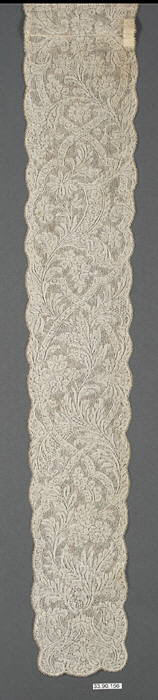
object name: lappet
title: Lappets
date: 1734-1766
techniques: lace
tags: flowers